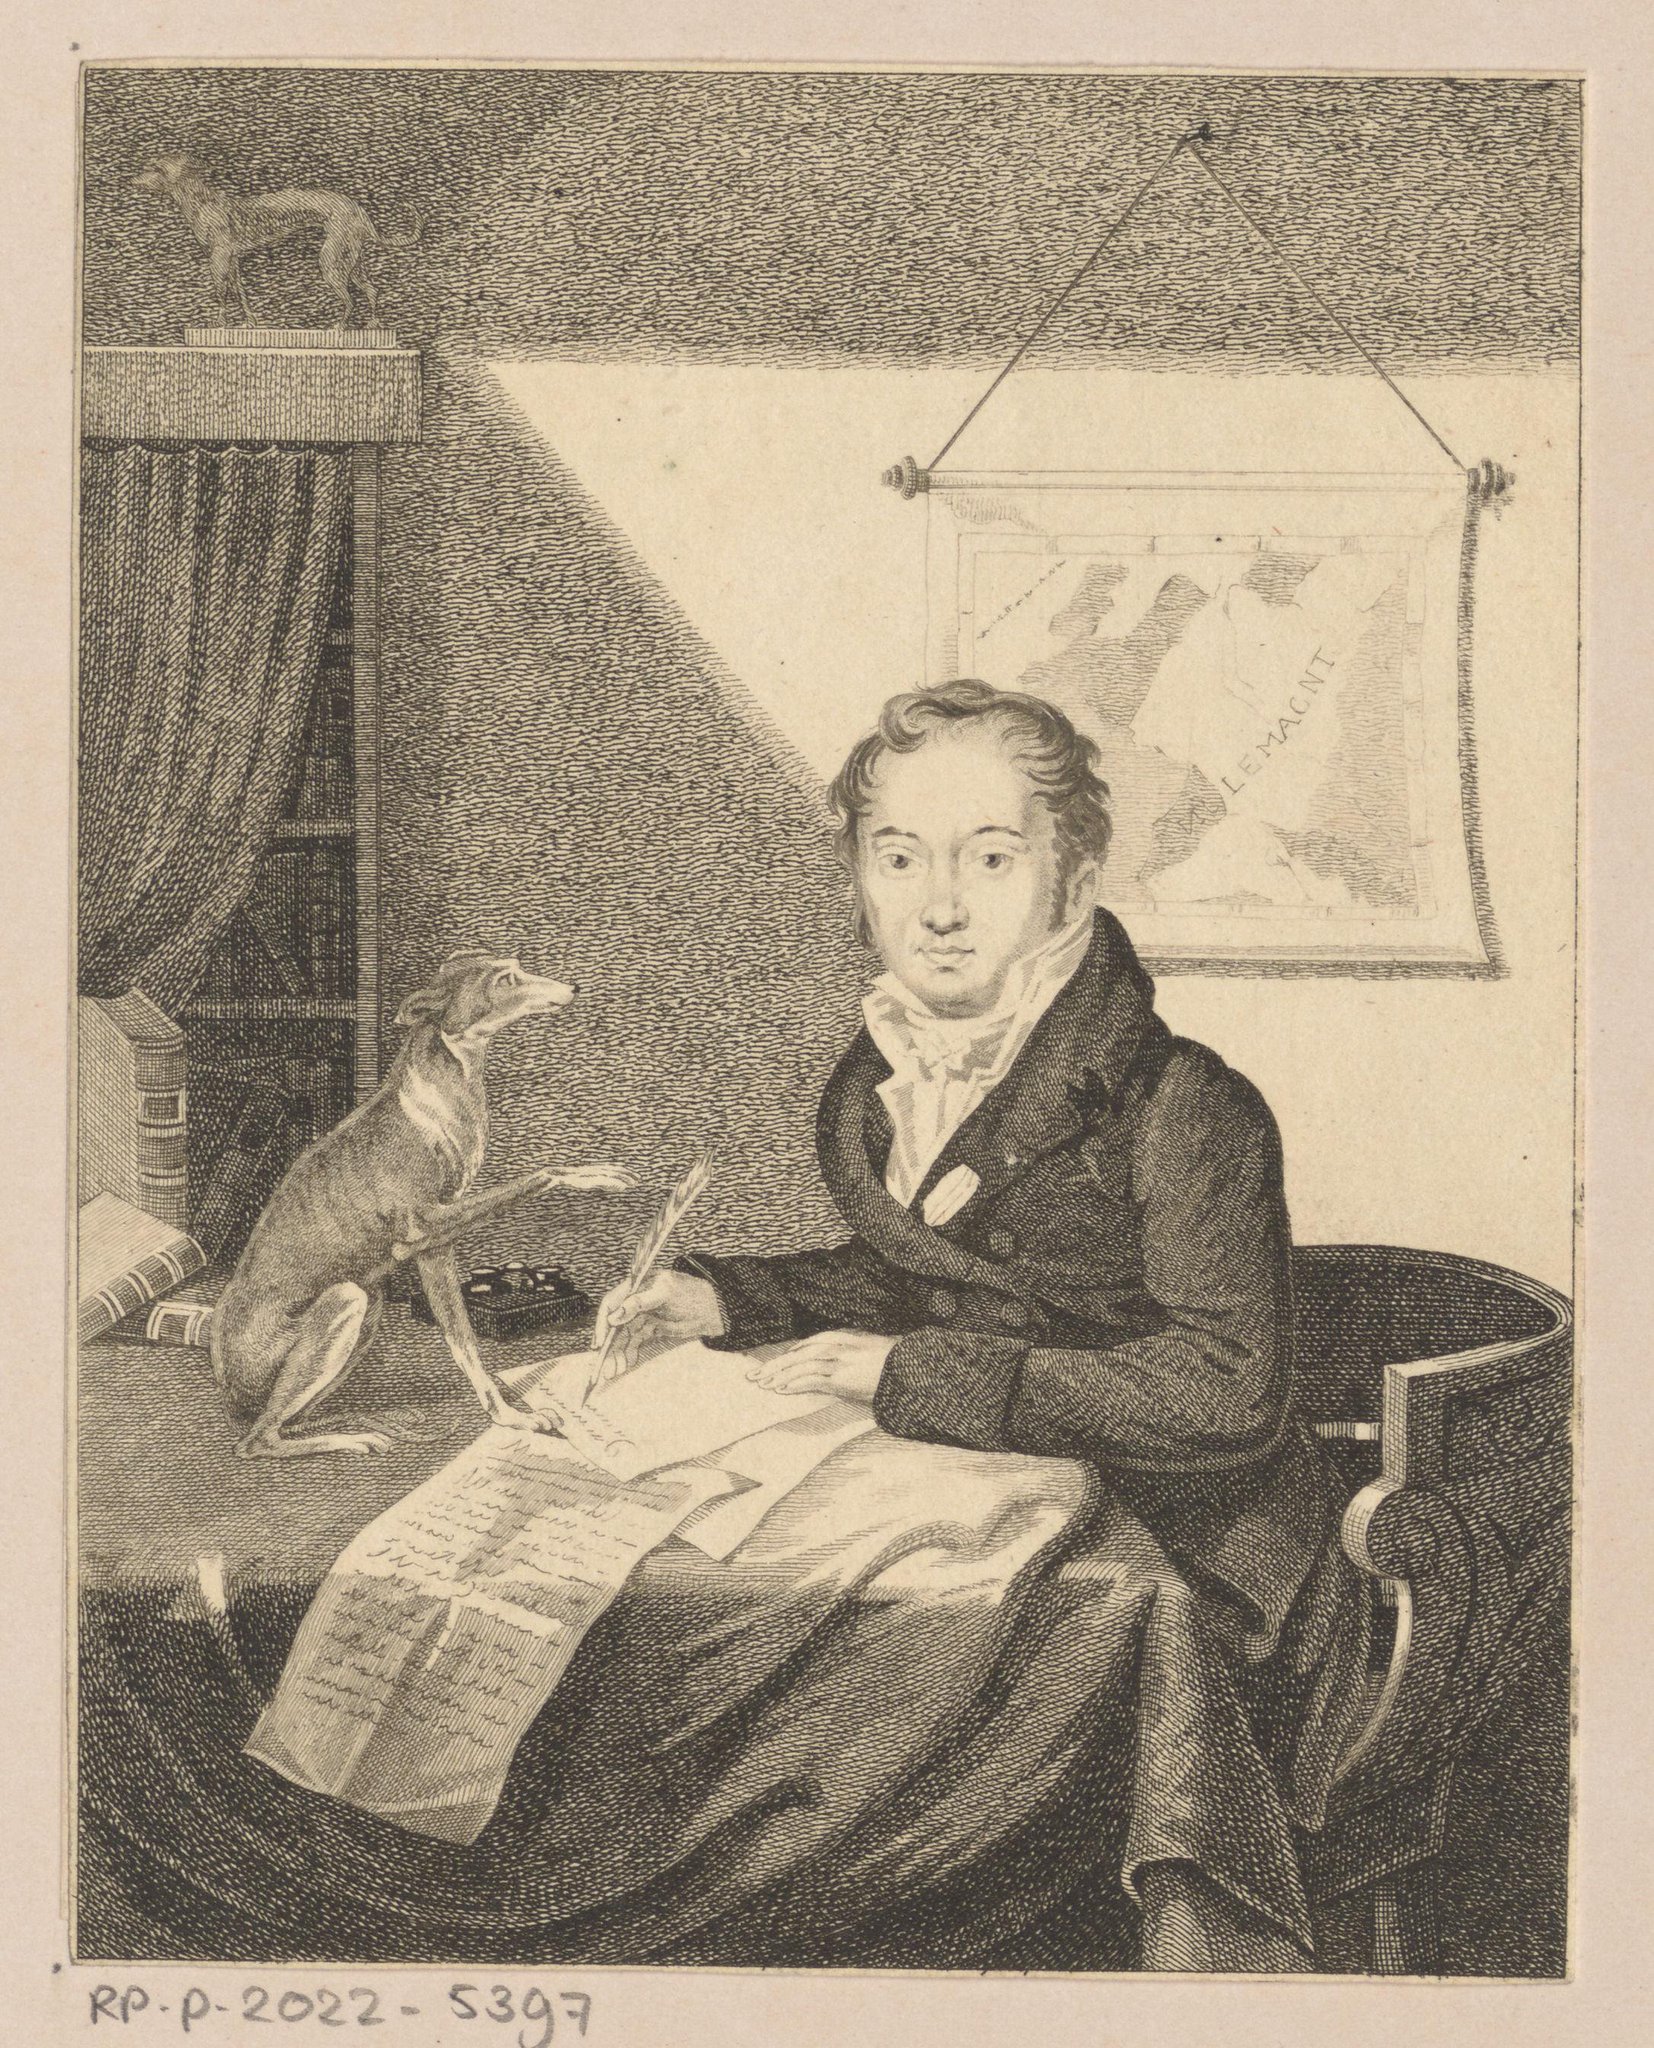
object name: print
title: Portret van Goswin Joseph Augustin de Stassart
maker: Anonymous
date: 1800-1850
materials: paper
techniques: etching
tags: historical persons, politician, e.g. party leader